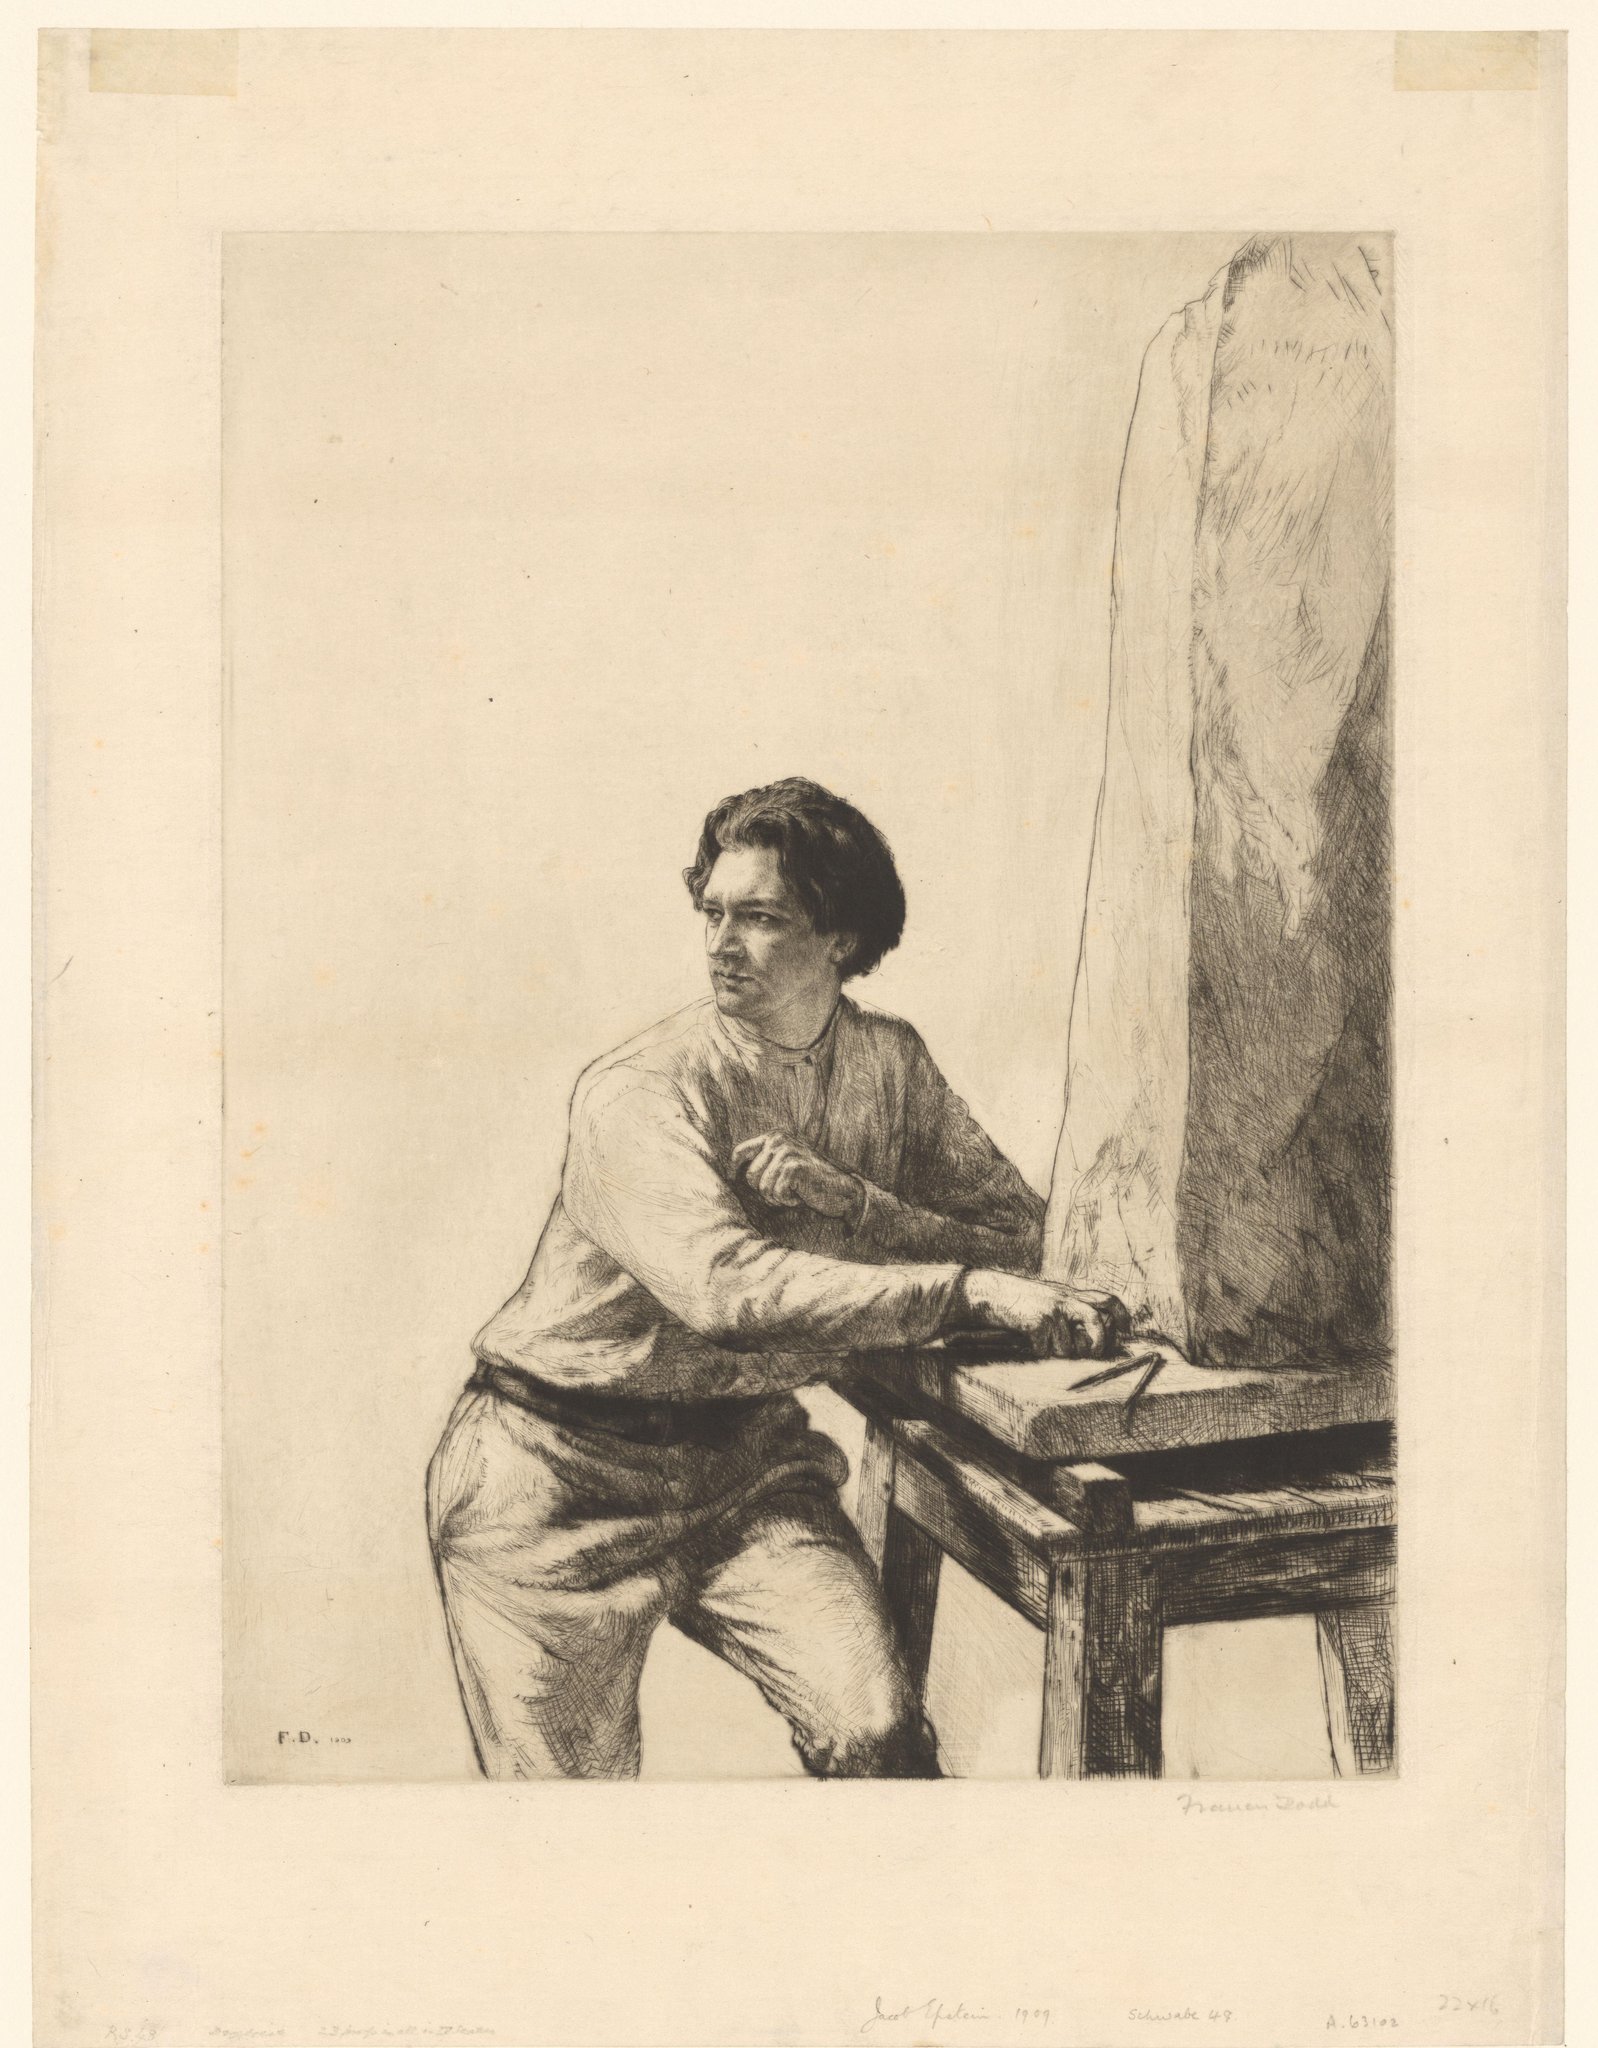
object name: print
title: Portret van Jacob Epstein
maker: francis dodd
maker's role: print maker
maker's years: 1874-1949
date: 1909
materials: paper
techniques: drypoint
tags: new york (city), london, sculptor, jacob epstein, portrait, self-portrait of sculptor (+ artist in non-work situation), historical persons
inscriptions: collector's mark: Lugt 2760, collector's mark: Lugt 2228